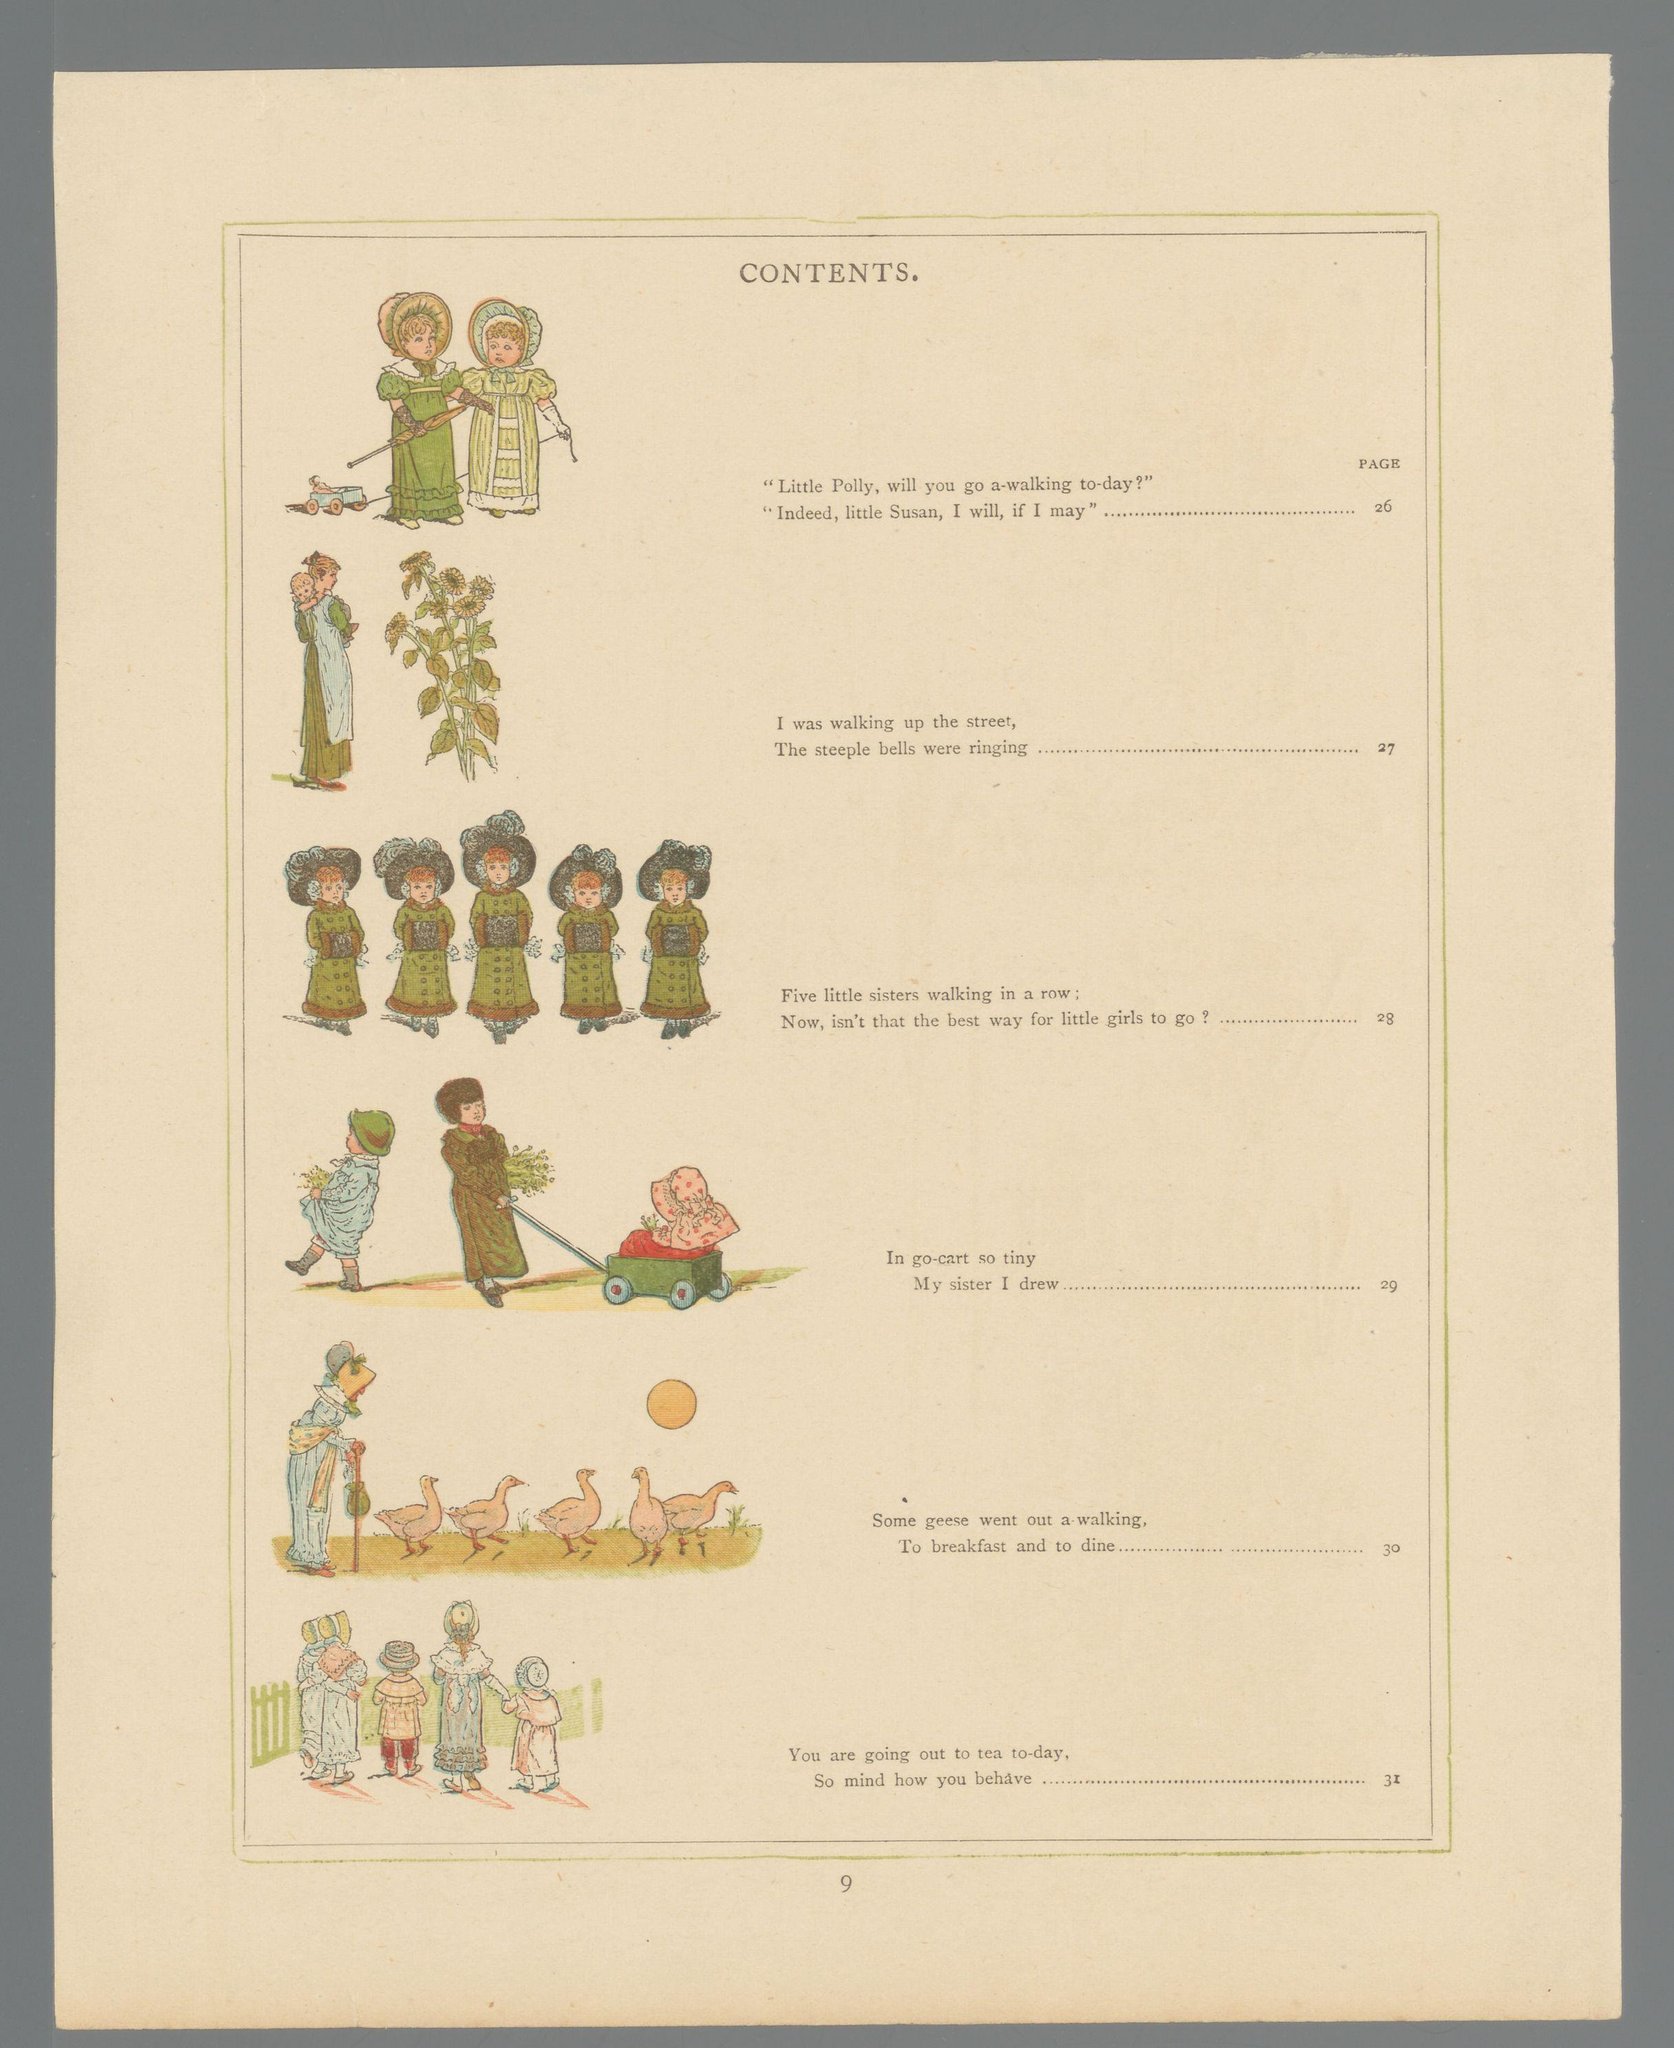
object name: table of content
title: Zes voorstellingen met kinderen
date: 1878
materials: paper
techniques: wood engraving, letterpress printing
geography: london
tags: child, family life at home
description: Prent uit: Greenaway, Kate. Under the window, pictures & rhymes for children. Londen: George Routledge & Sons, 1878, p. 9.